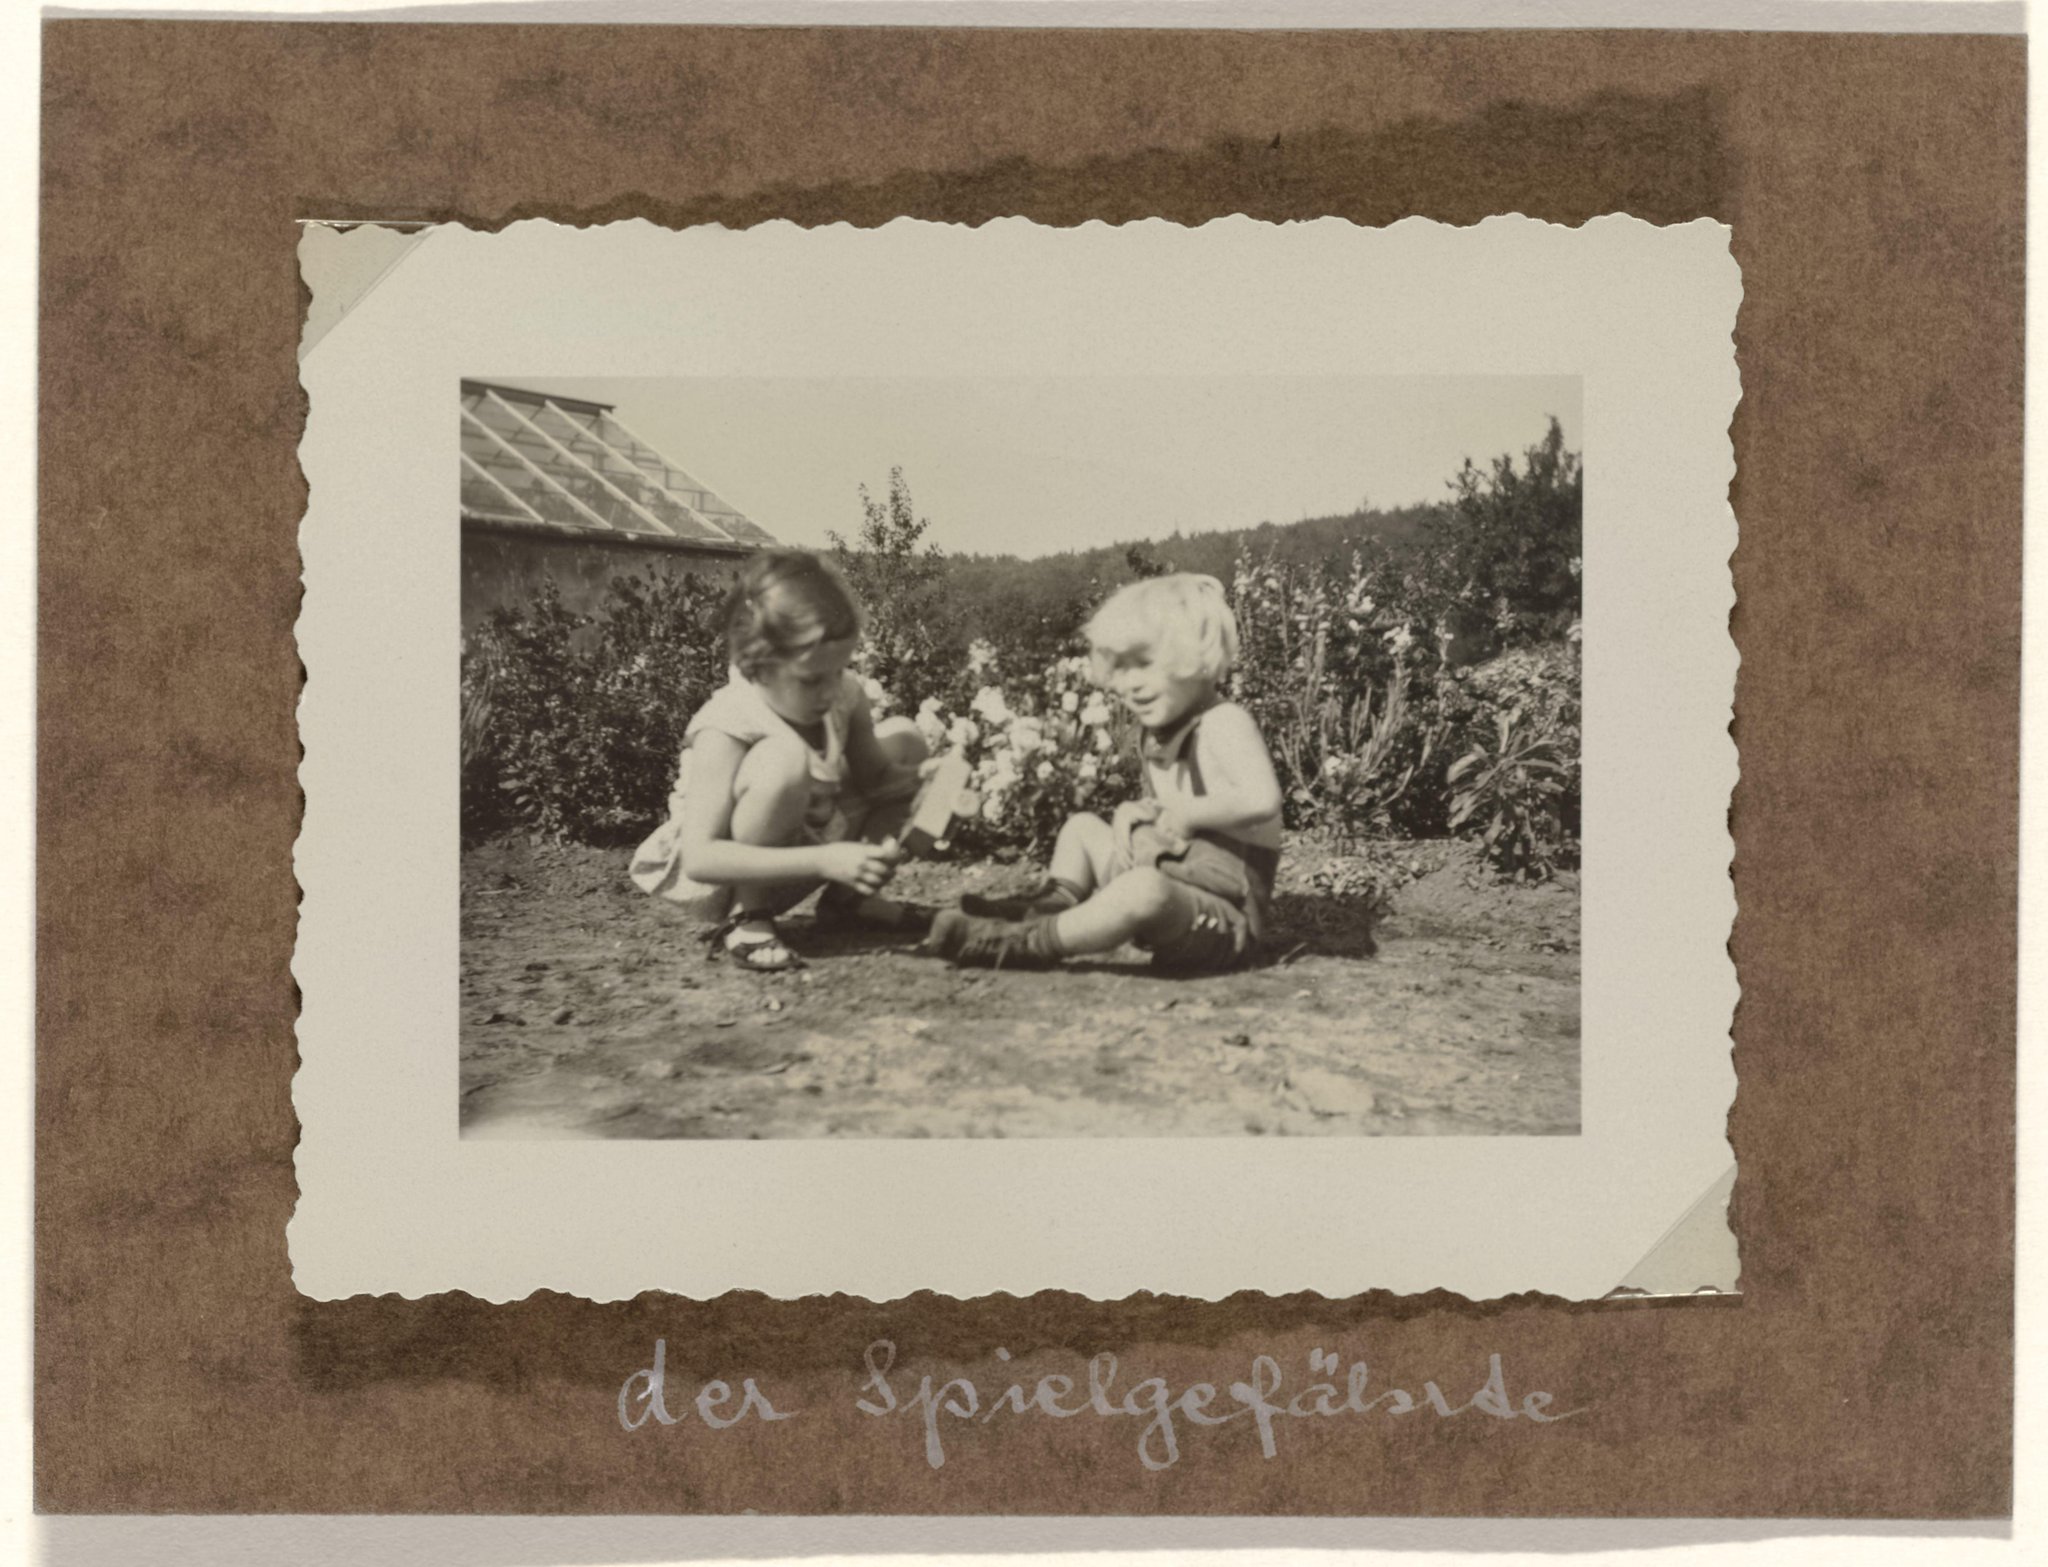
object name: photograph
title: Isabel Wachenheimer met een kind spelend in een tuin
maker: Anonymous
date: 1930-1934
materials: photographic support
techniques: gelatin silver print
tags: isabel wachenheimer-elon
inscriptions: inscription: ‘der Spielgefälsste’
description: Isabel Wachenheimer (links) met een onbekend kind spelend in een tuin.